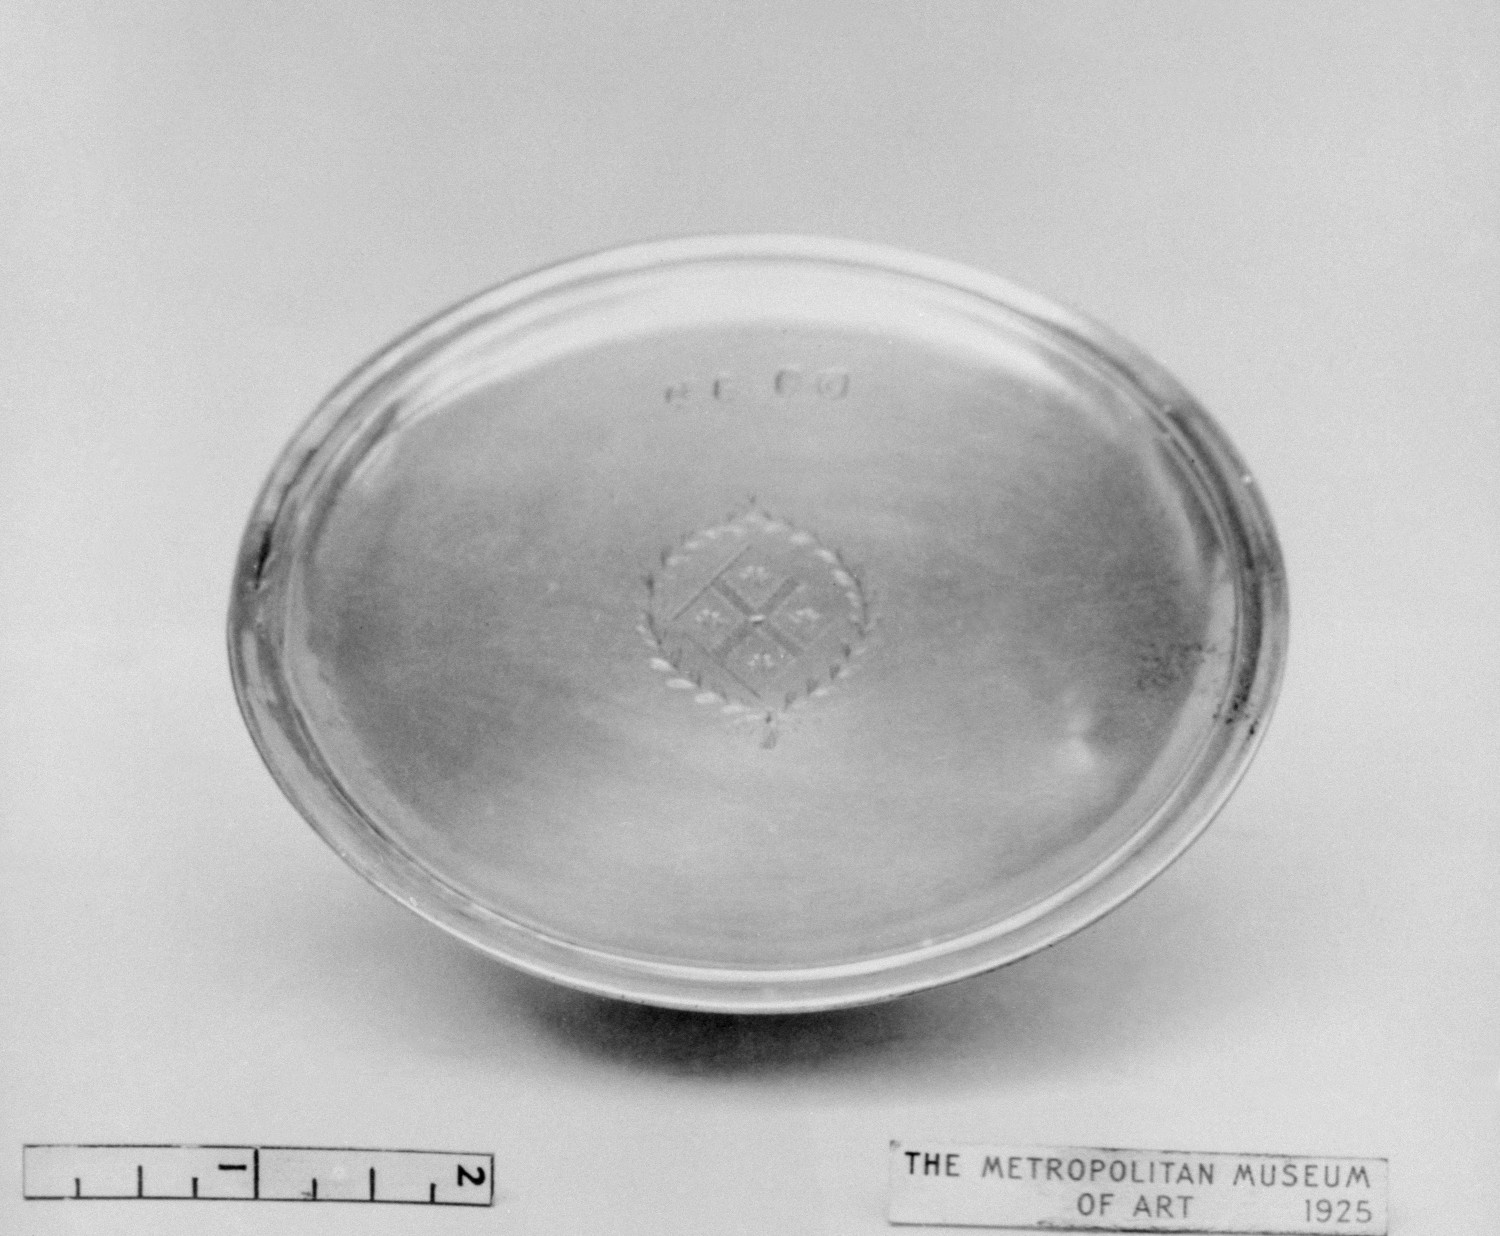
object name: paten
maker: john sanders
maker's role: maker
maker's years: 1717-1748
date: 1718-1719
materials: silver